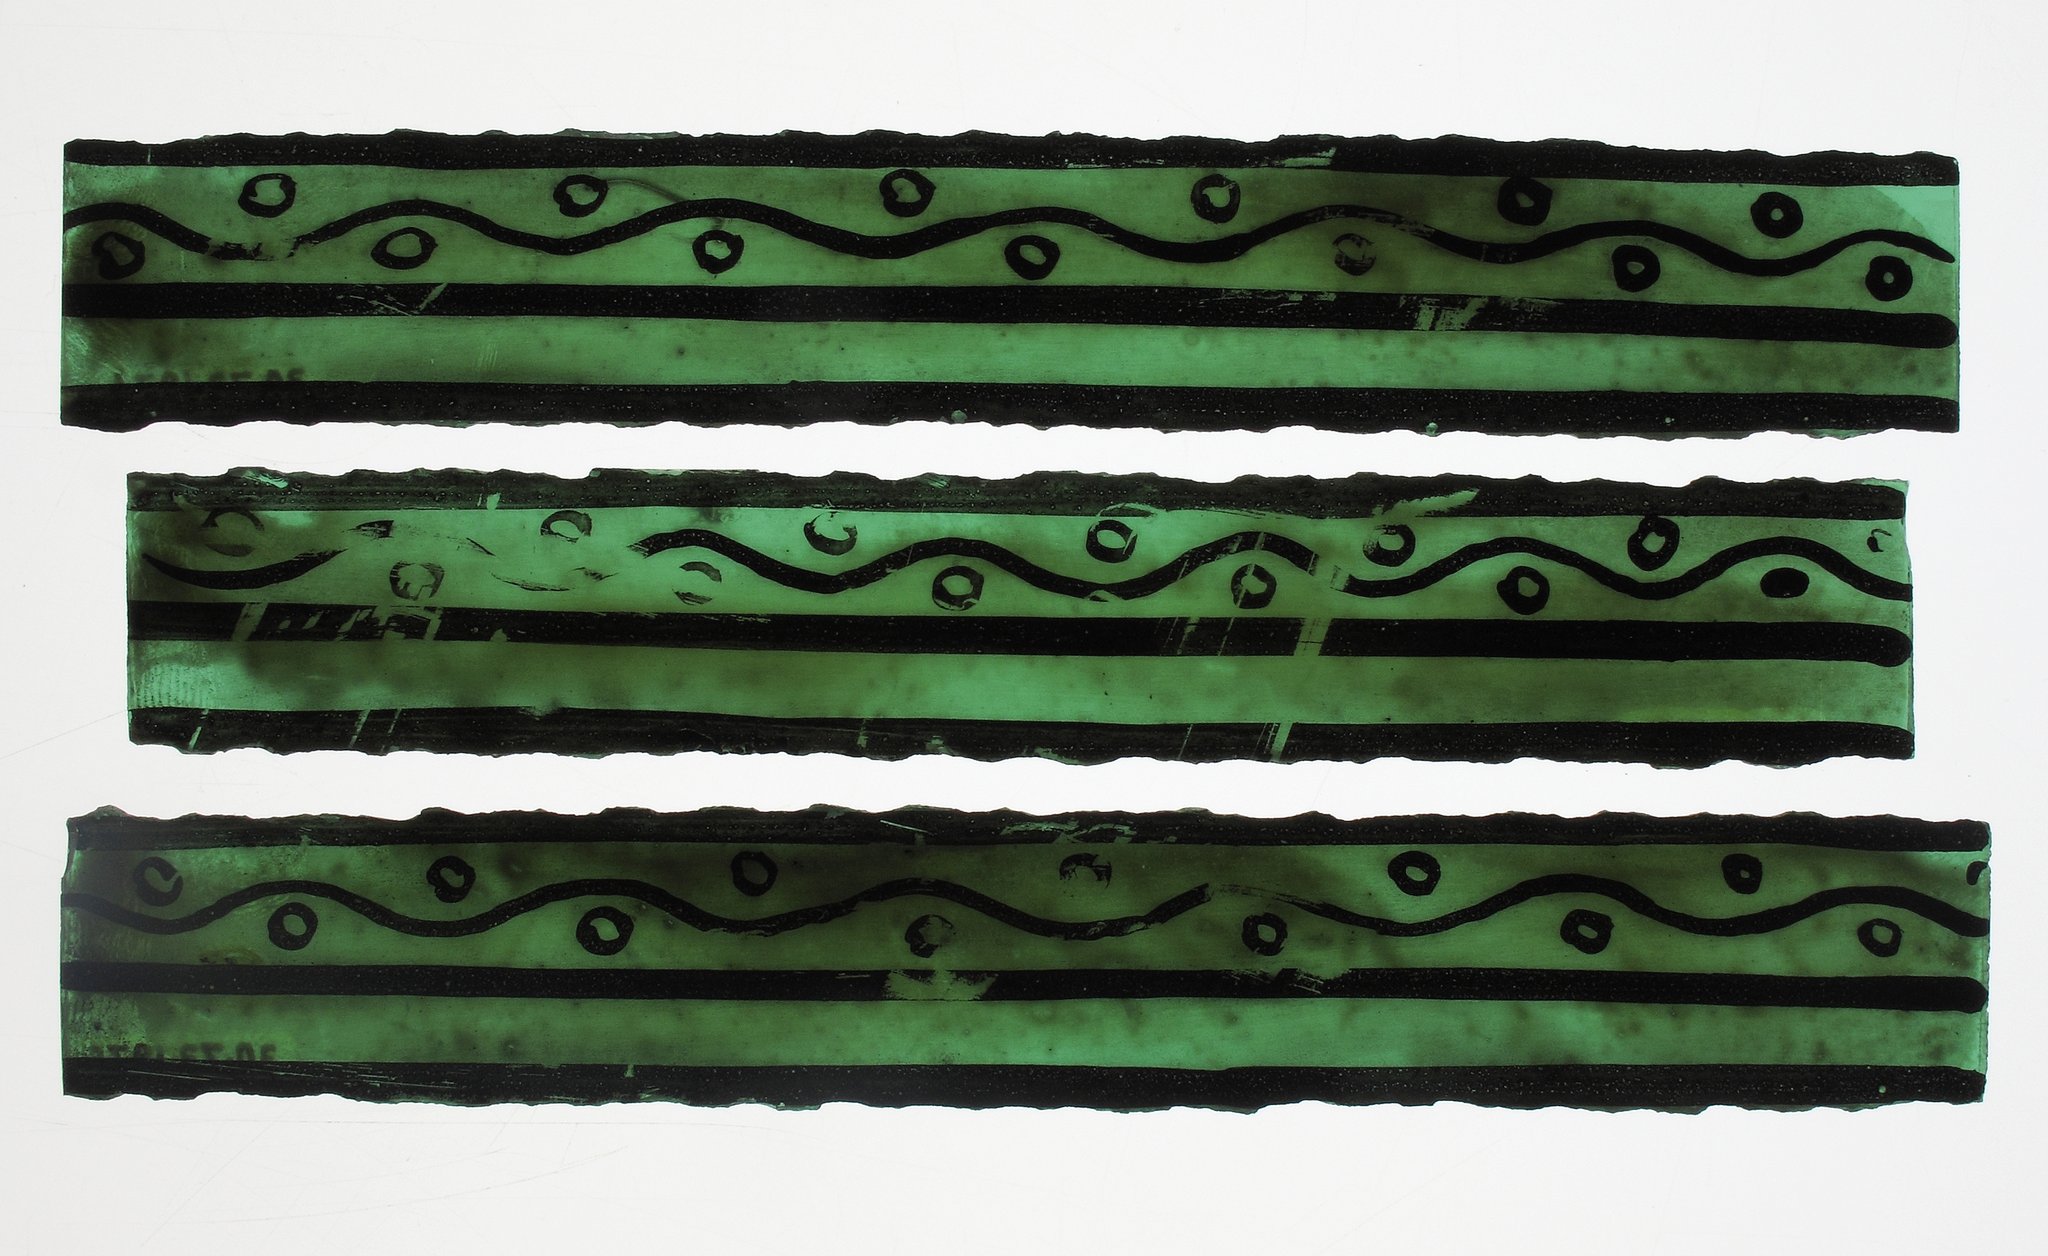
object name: fragment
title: Glass Fragment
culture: french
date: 1301-1400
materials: glass, metal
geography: france